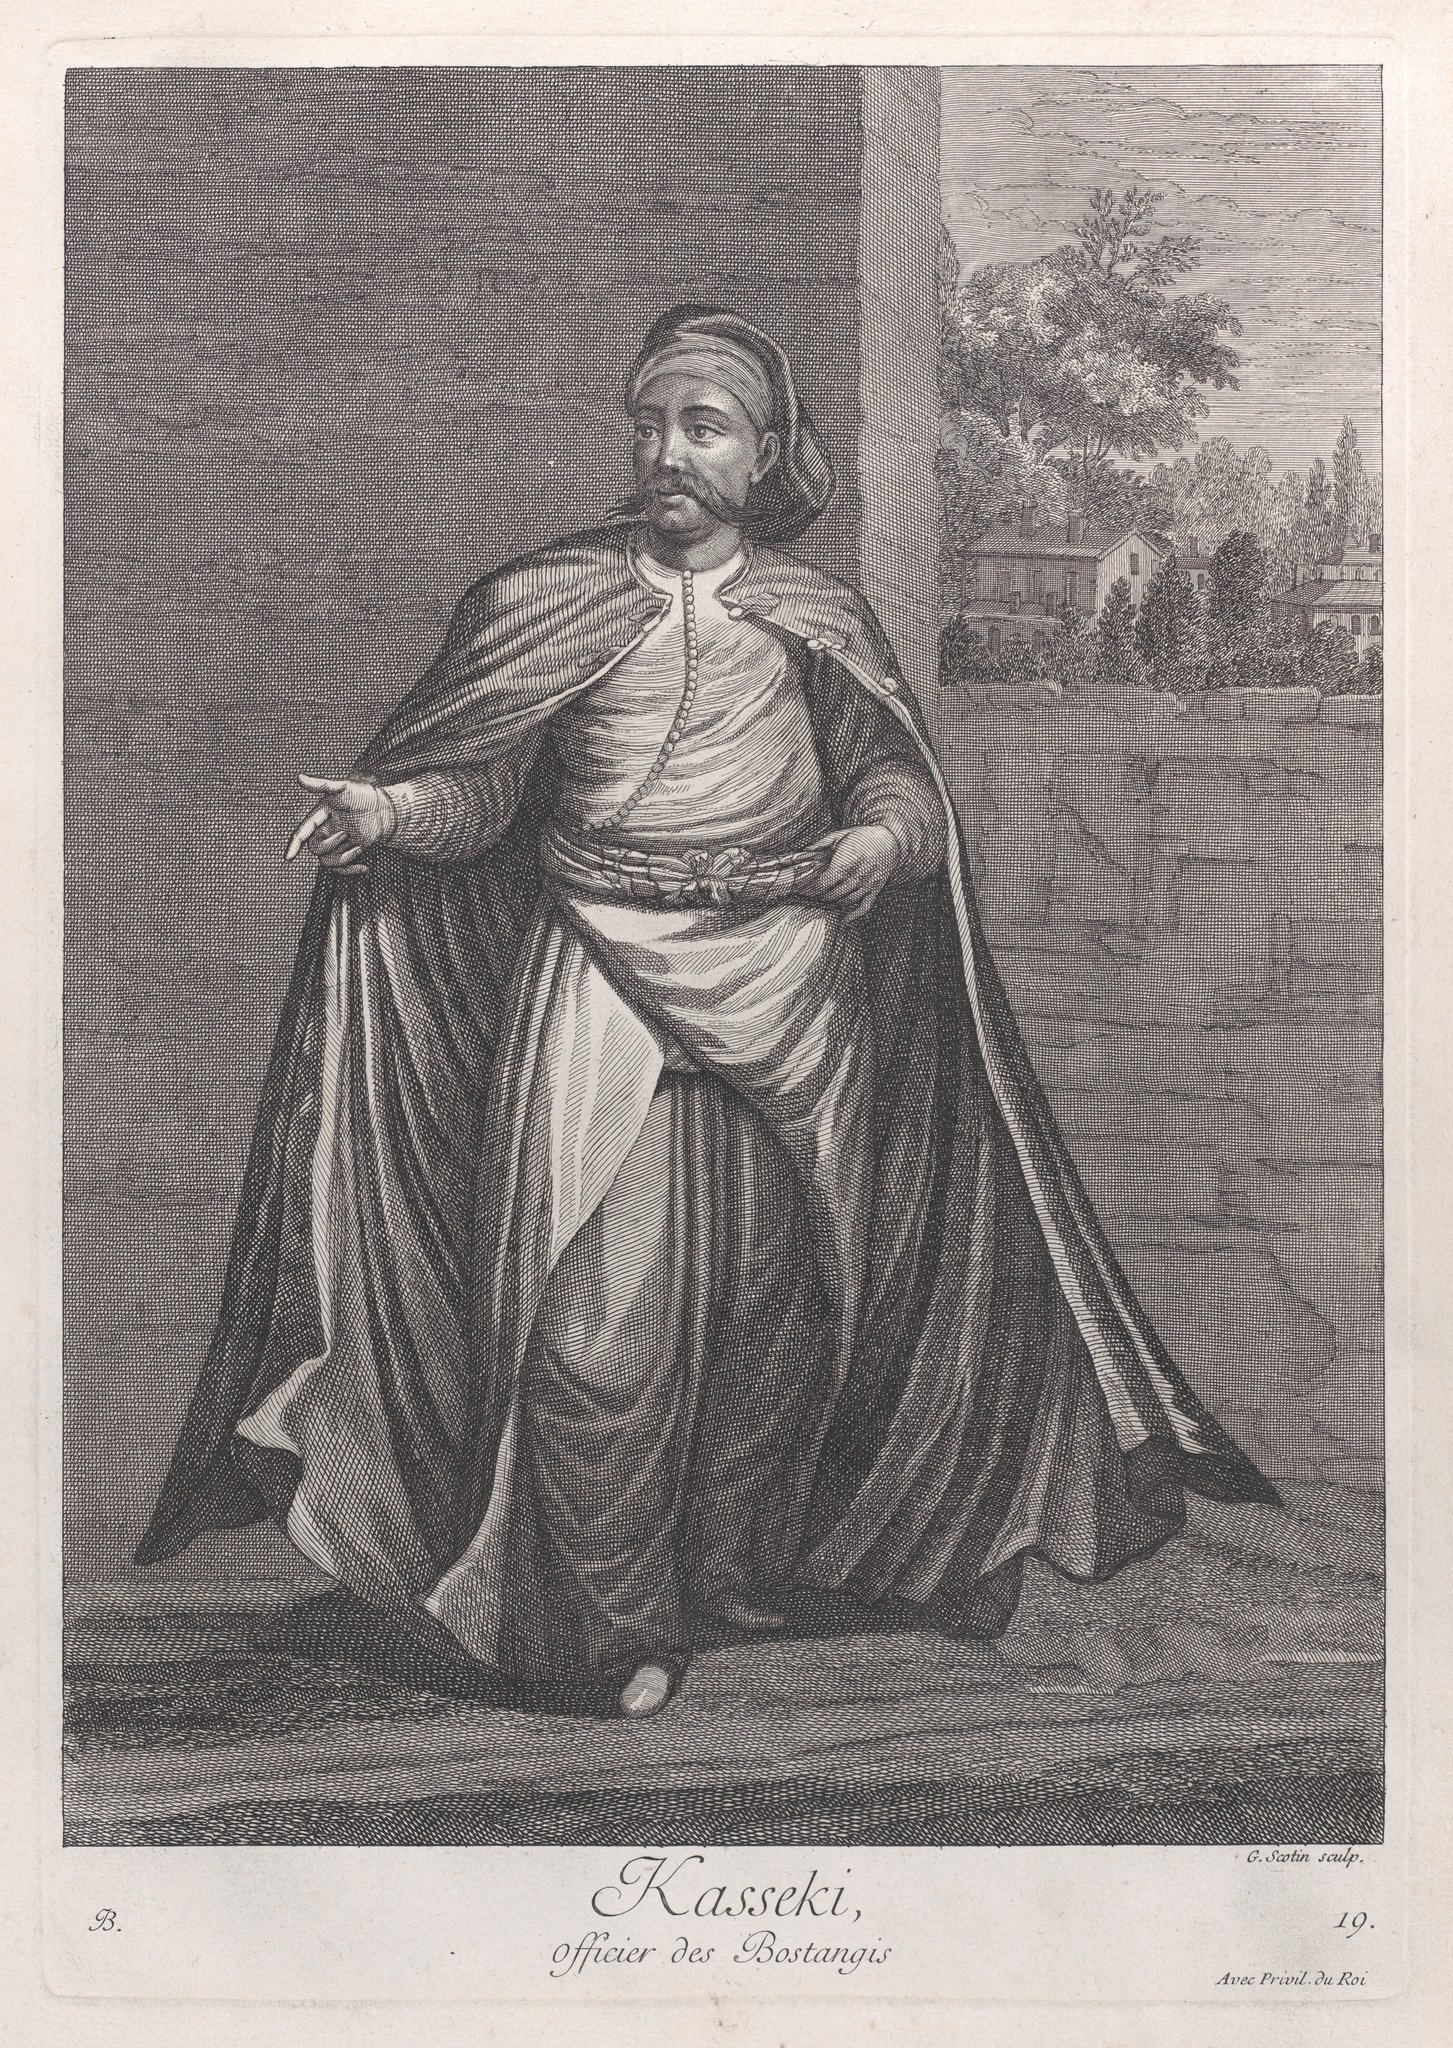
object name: print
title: Kasseki, officier des Bostangis, plate 19 from "Recueil de cent estampes représentent differentes nations du Levant"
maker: jean baptiste vanmour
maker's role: artist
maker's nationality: french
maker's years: 1671-1737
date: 1714-1715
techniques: engraving, etching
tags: men